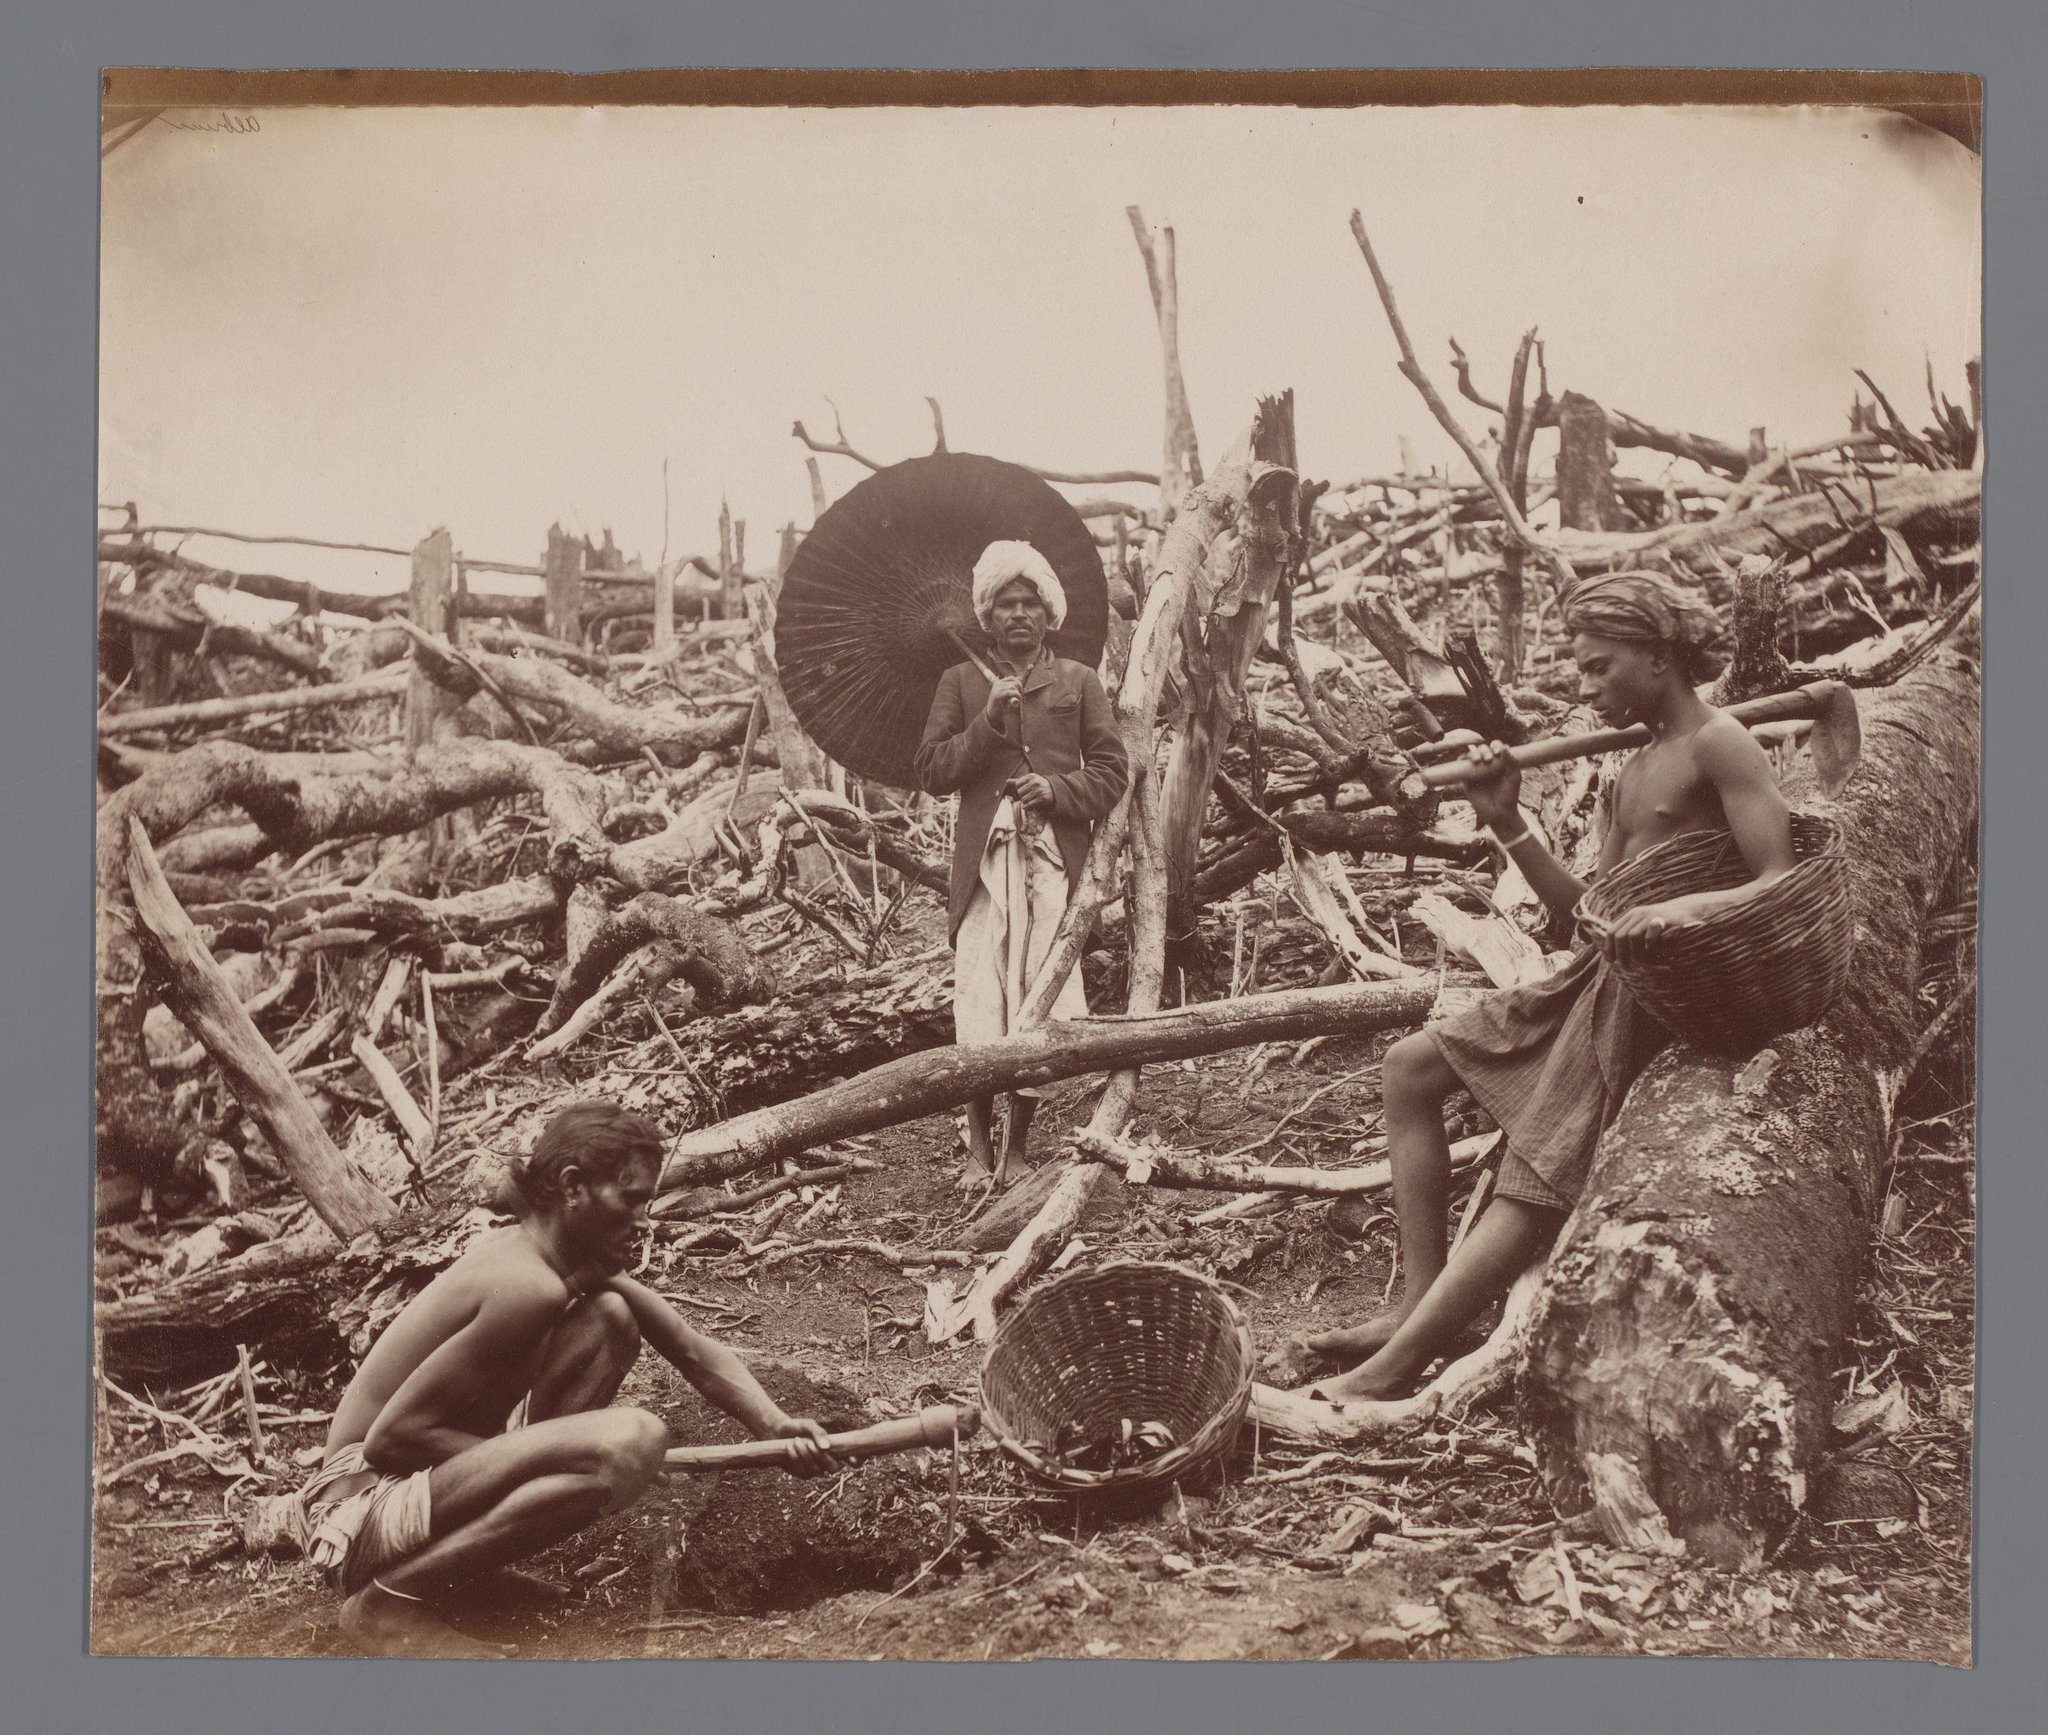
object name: photograph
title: Searching for cinchona, India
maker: Anonymous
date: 1870-1890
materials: paper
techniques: albumen print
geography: india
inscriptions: inscription: ‘Sytten Clu [?]’, inscription: ‘Roling [?] for Cinchona’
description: Drie mannen temidden van verdord hout, één ervan met paraplu staand in het midden, de andere twee aan weerszijden met schop en manden.